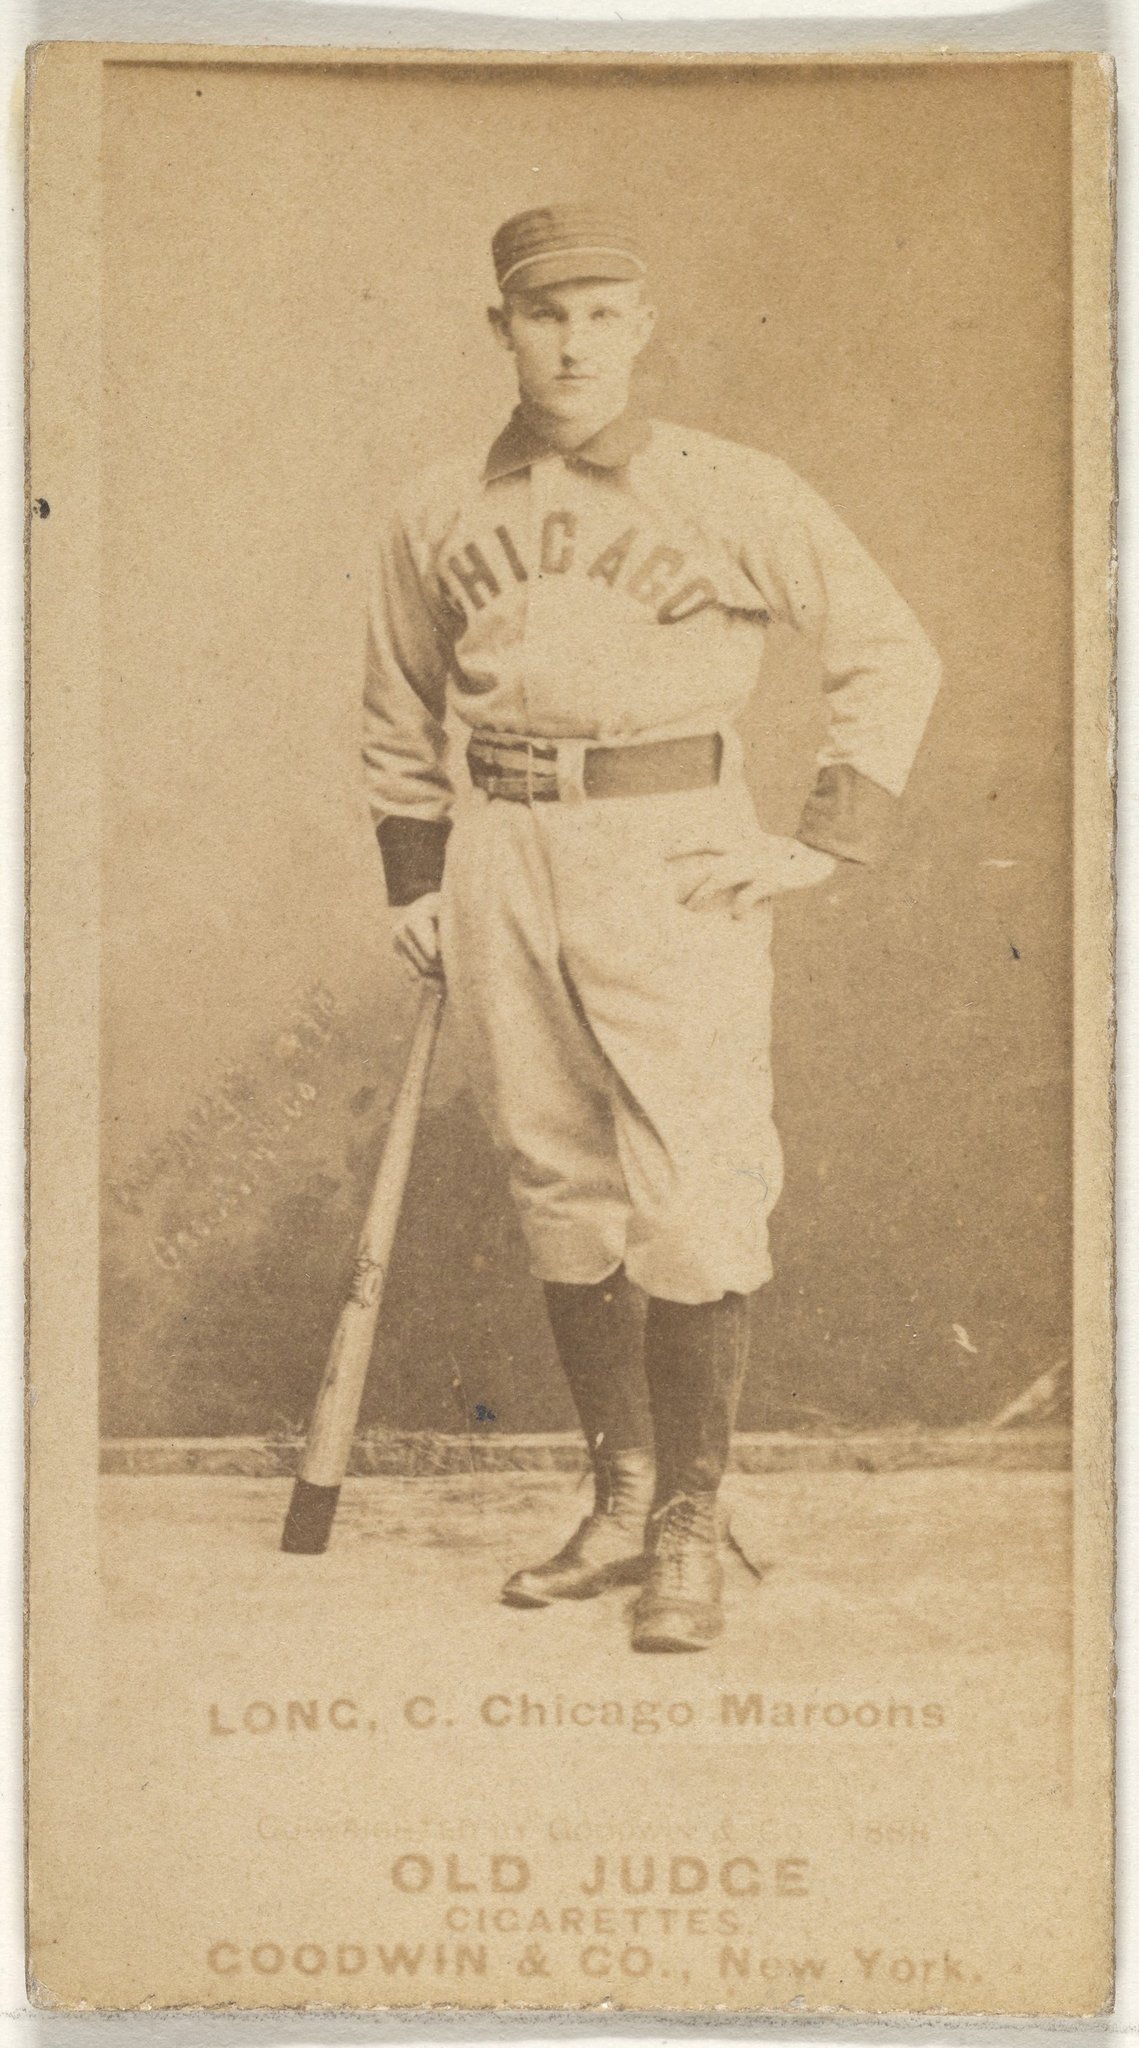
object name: baseball card, photograph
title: Long, Catcher, Chicago, from the Old Judge series (N172) for Old Judge Cigarettes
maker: goodwin & company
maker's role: publisher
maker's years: 1850-1950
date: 1887-1890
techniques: albumen silver print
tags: men,portraits,baseball,athletes